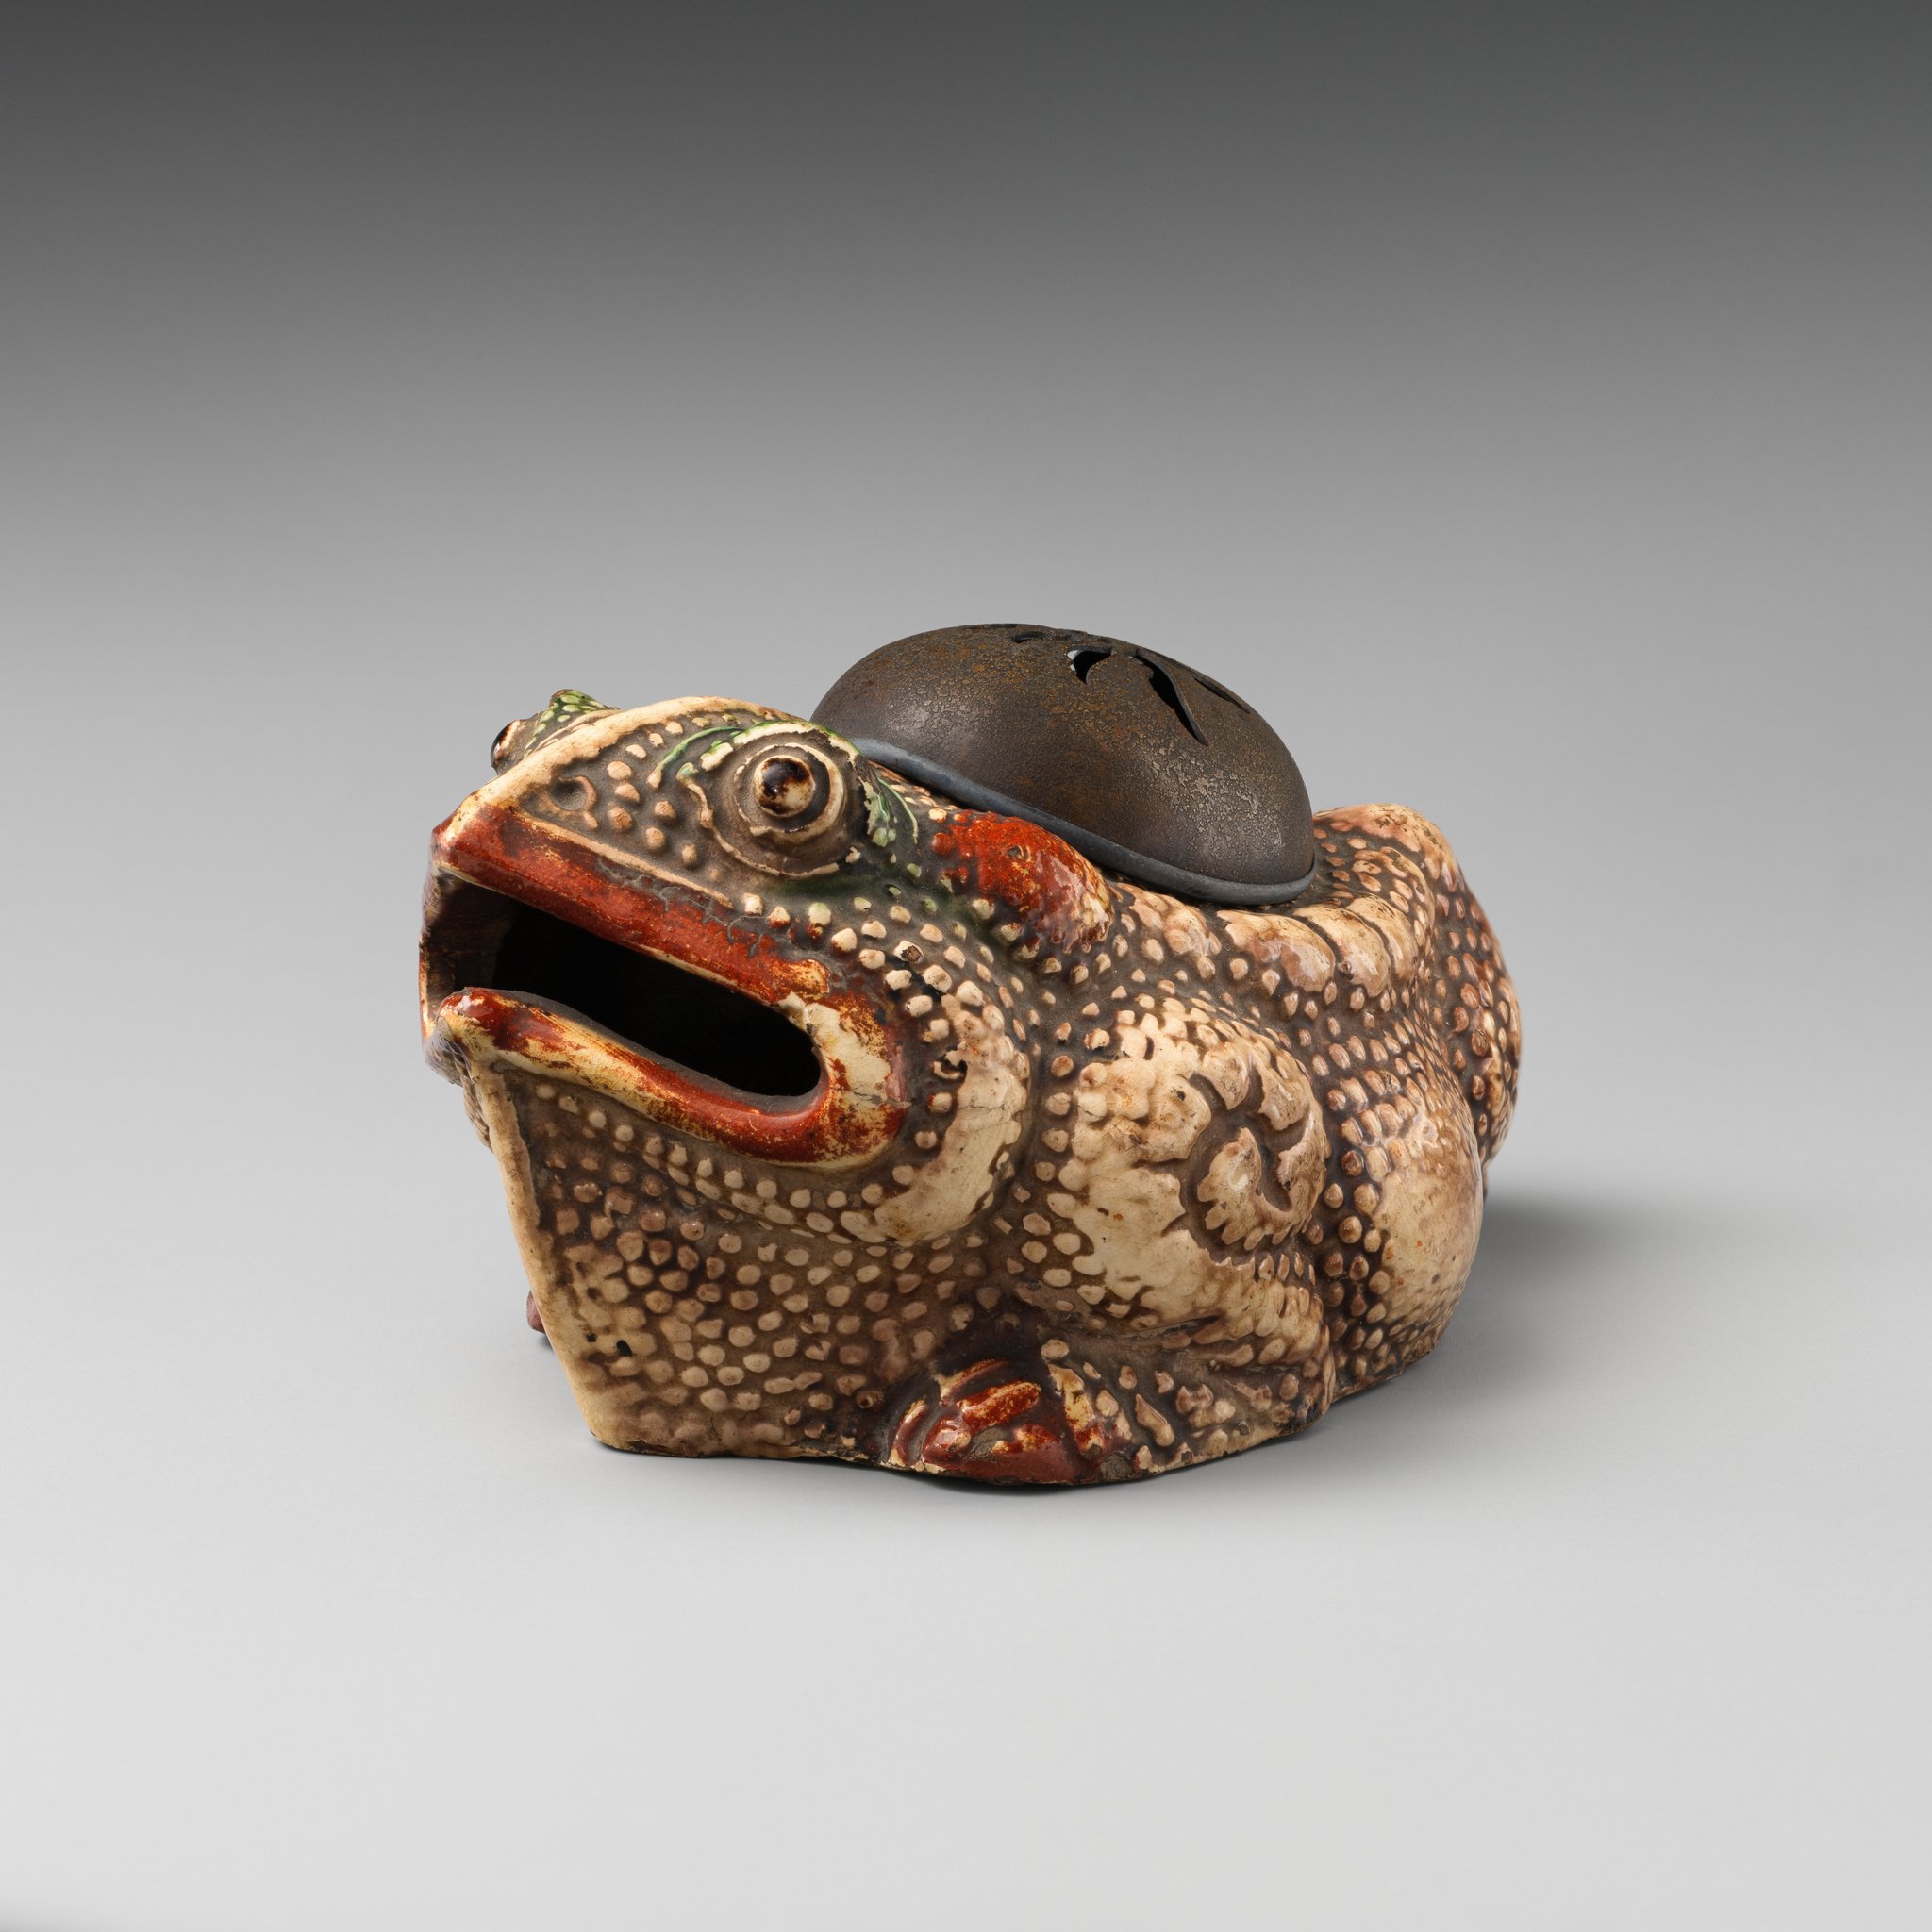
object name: incense burner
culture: japanese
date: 1801-1833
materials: pottery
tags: frogs